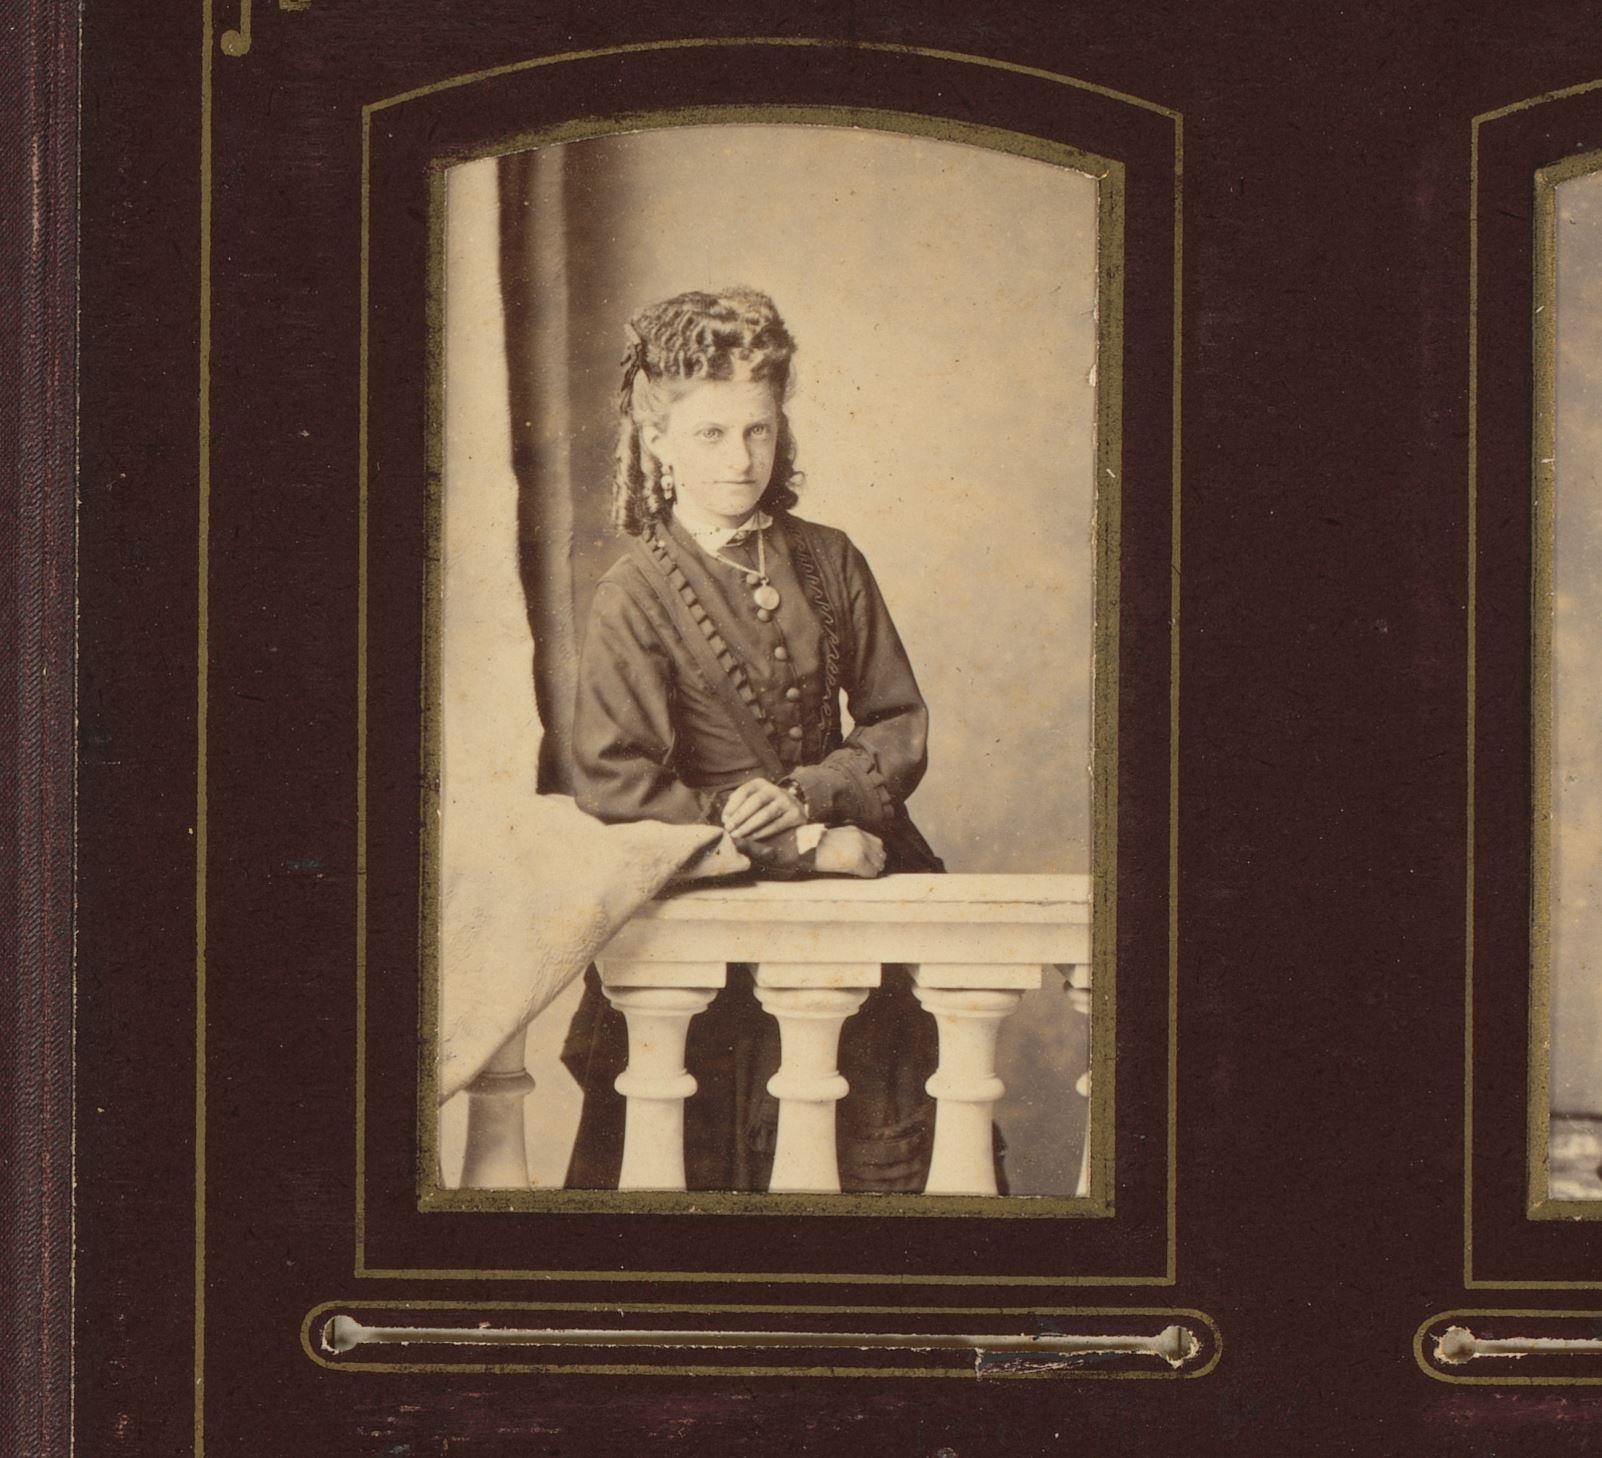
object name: album leaf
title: Portret van een vrouw, leunend op een balustrade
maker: a. böeseken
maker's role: fotograaf, lithograaf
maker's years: 1834-1919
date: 1858-1890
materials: cardboard, photographic support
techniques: albumen print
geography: rotterdam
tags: historical persons - bb - woman, balustrade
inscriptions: inscription: ‘A. Böeseken/ Photographisch Atelier/ ROTTERDAM/ Hoogstraat over de Vlasmarkt’